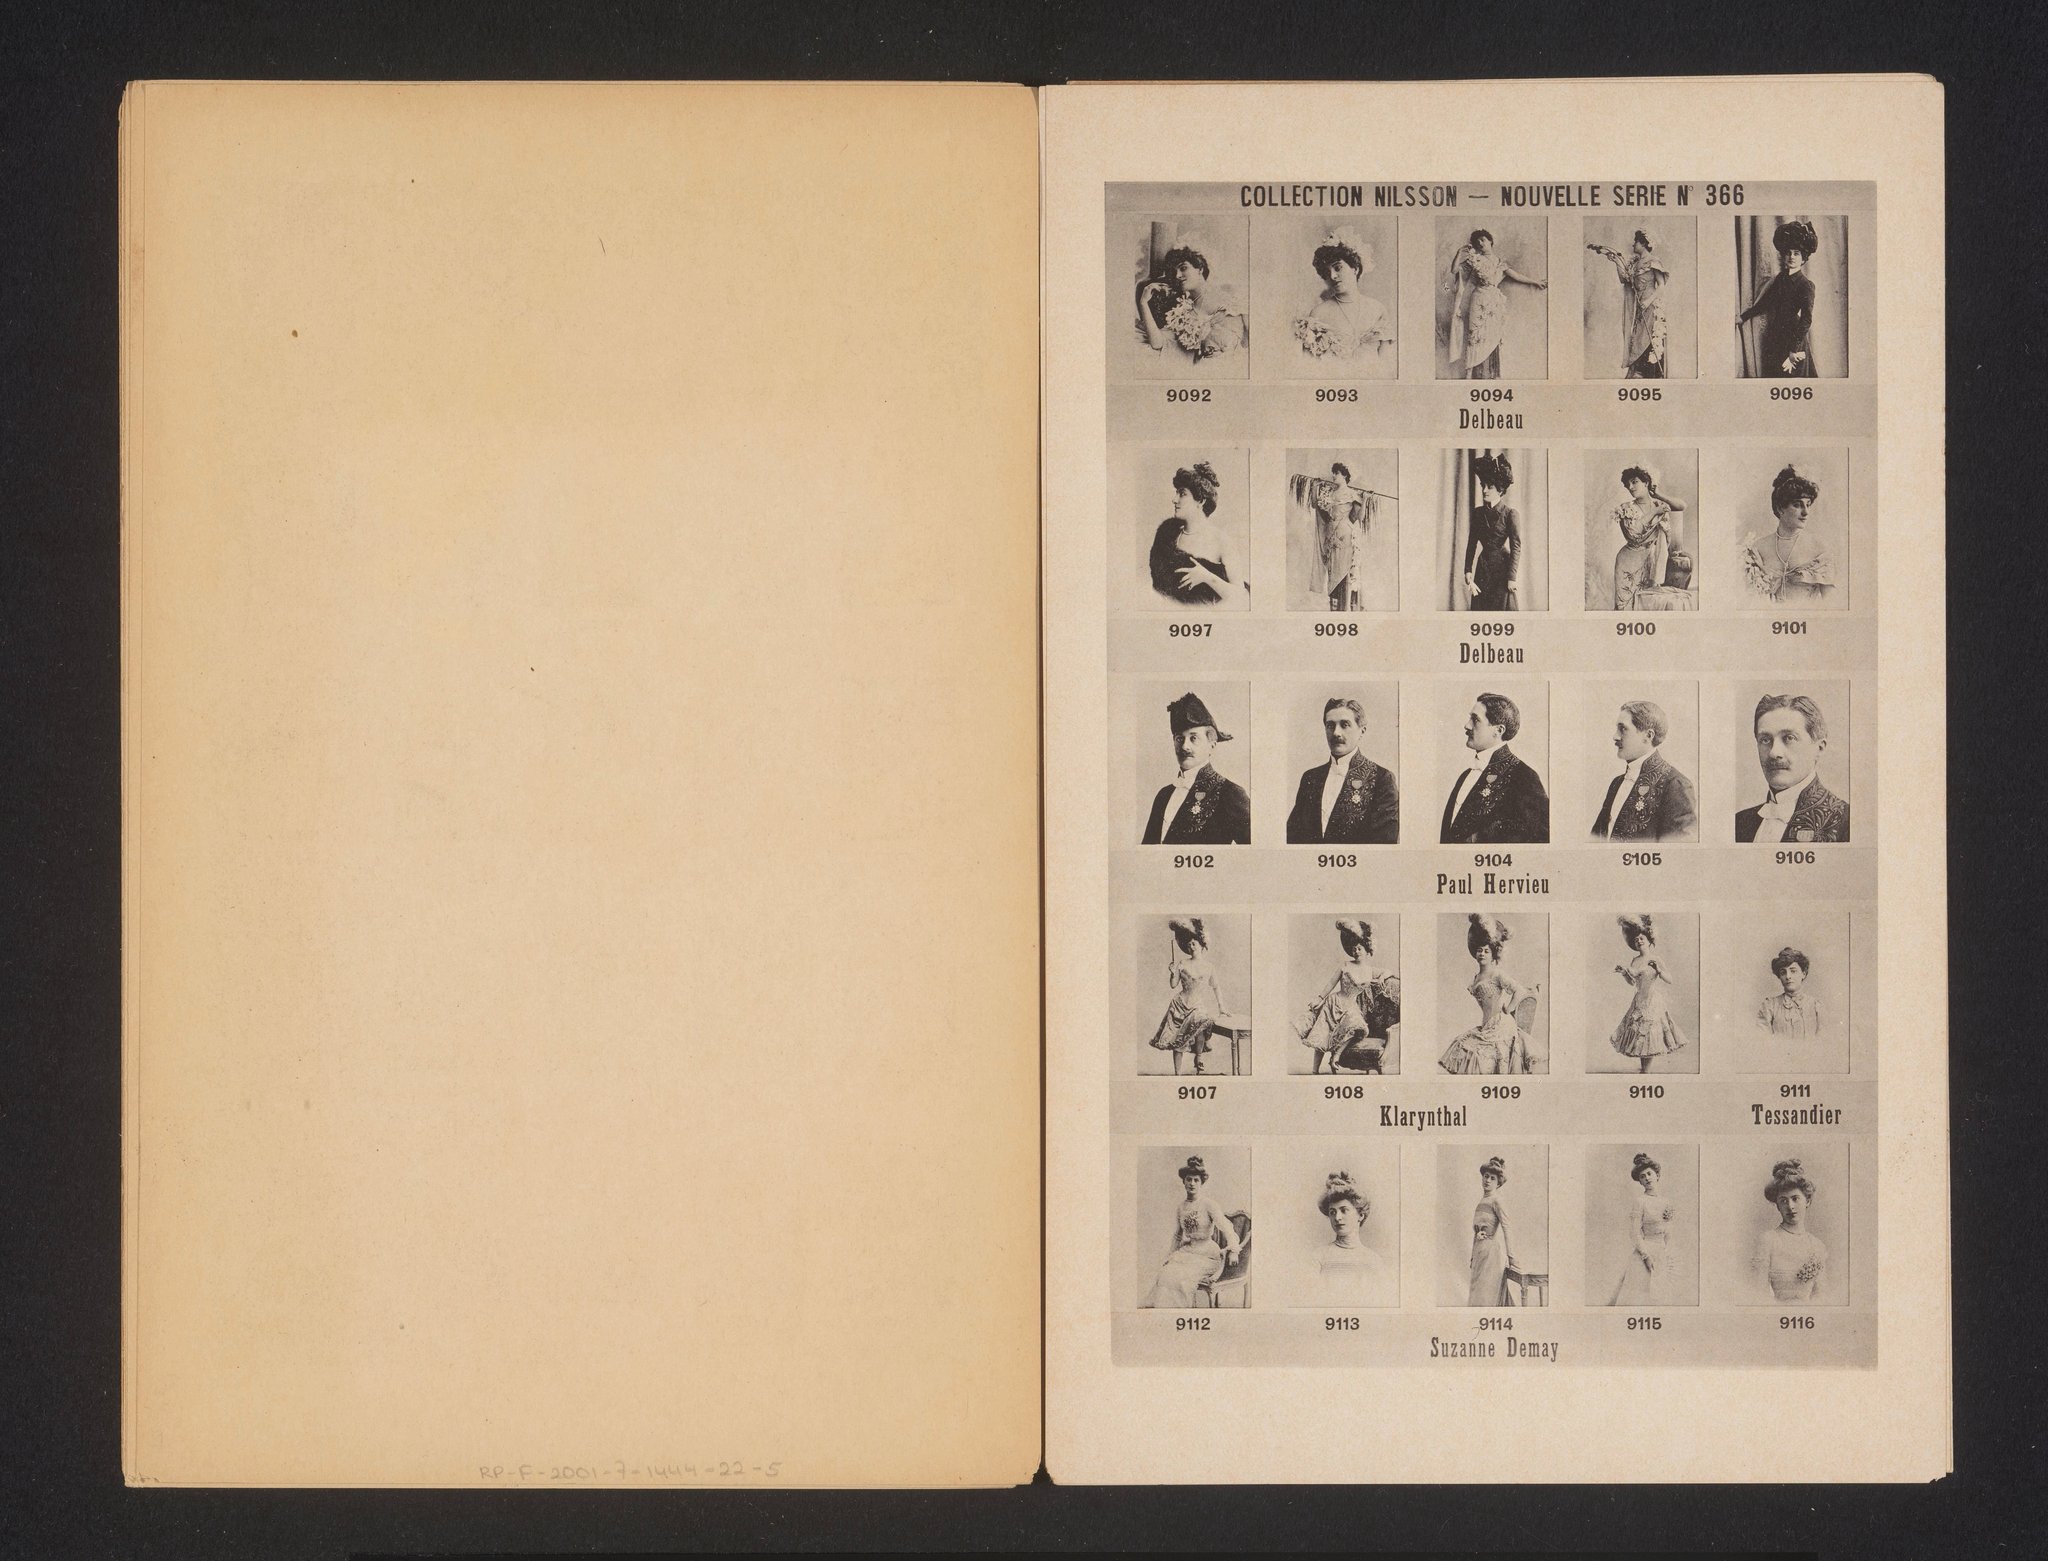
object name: page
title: 25 portretten van Delbeau, Paul Hervieu, Klarynthal, Tessandier en Suzanne Demay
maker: Anonymous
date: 1895-1900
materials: paper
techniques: photograph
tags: paris, historical persons - bb - woman, historical persons, portrait of a writer, portrait of actor, actress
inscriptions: number: ‘No 366’